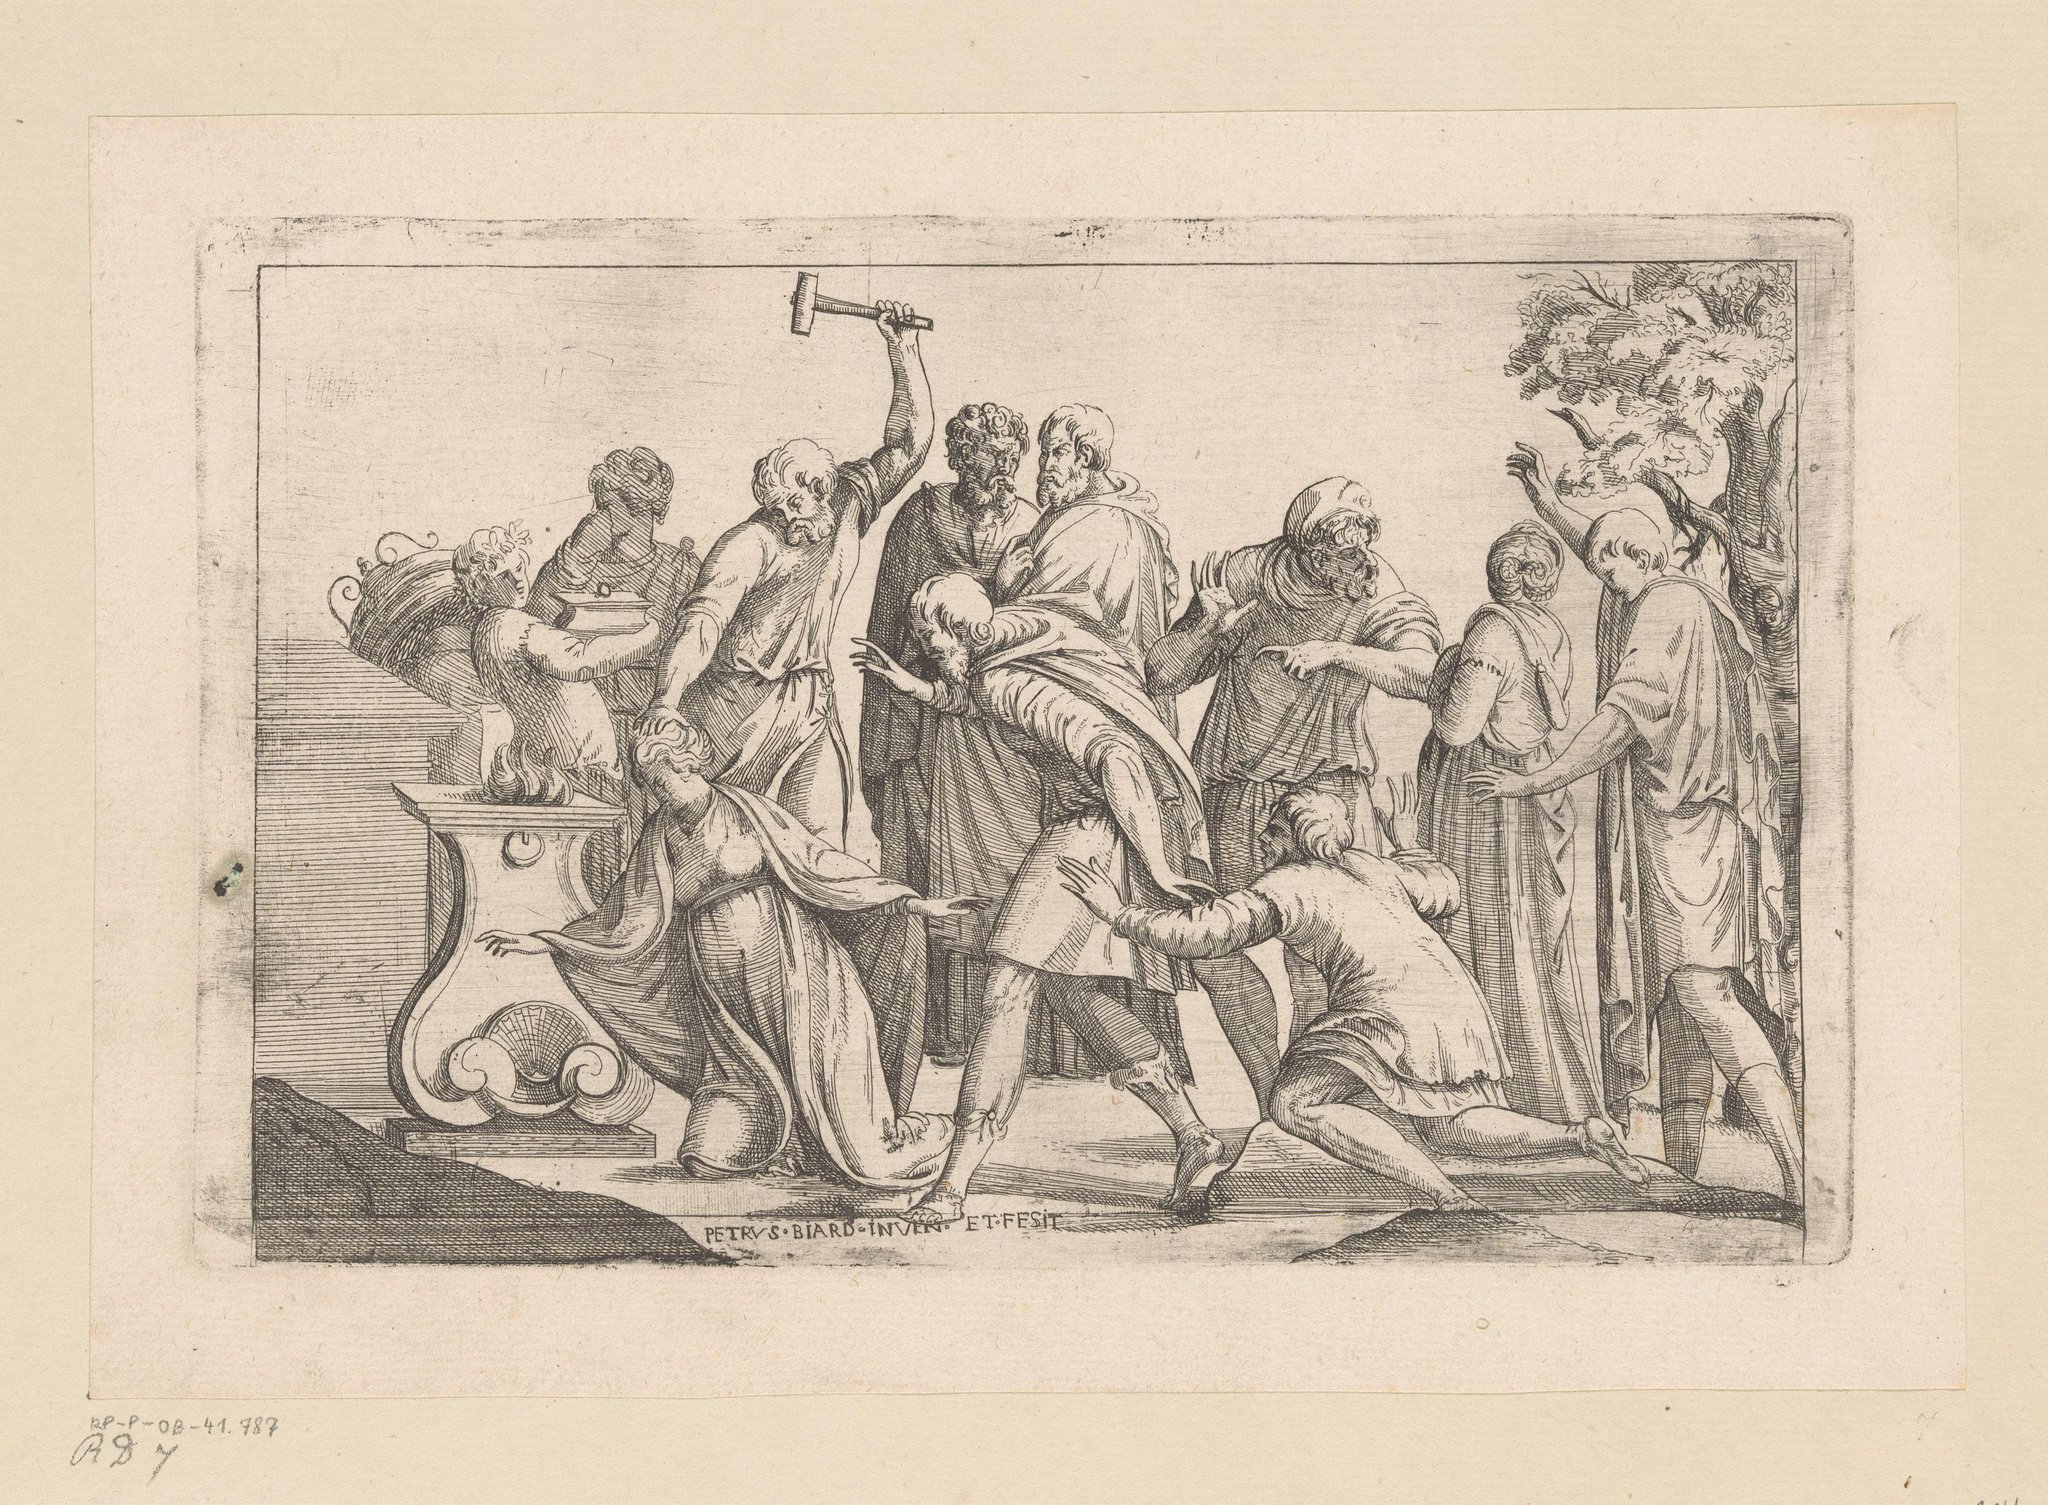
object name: print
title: Offer van Iphigenia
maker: pierre ii biard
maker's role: print maker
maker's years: 1592-1661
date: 1602-1661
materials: paper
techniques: etching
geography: france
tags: (story of) iphigenia - death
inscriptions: collector's mark: Lugt 240